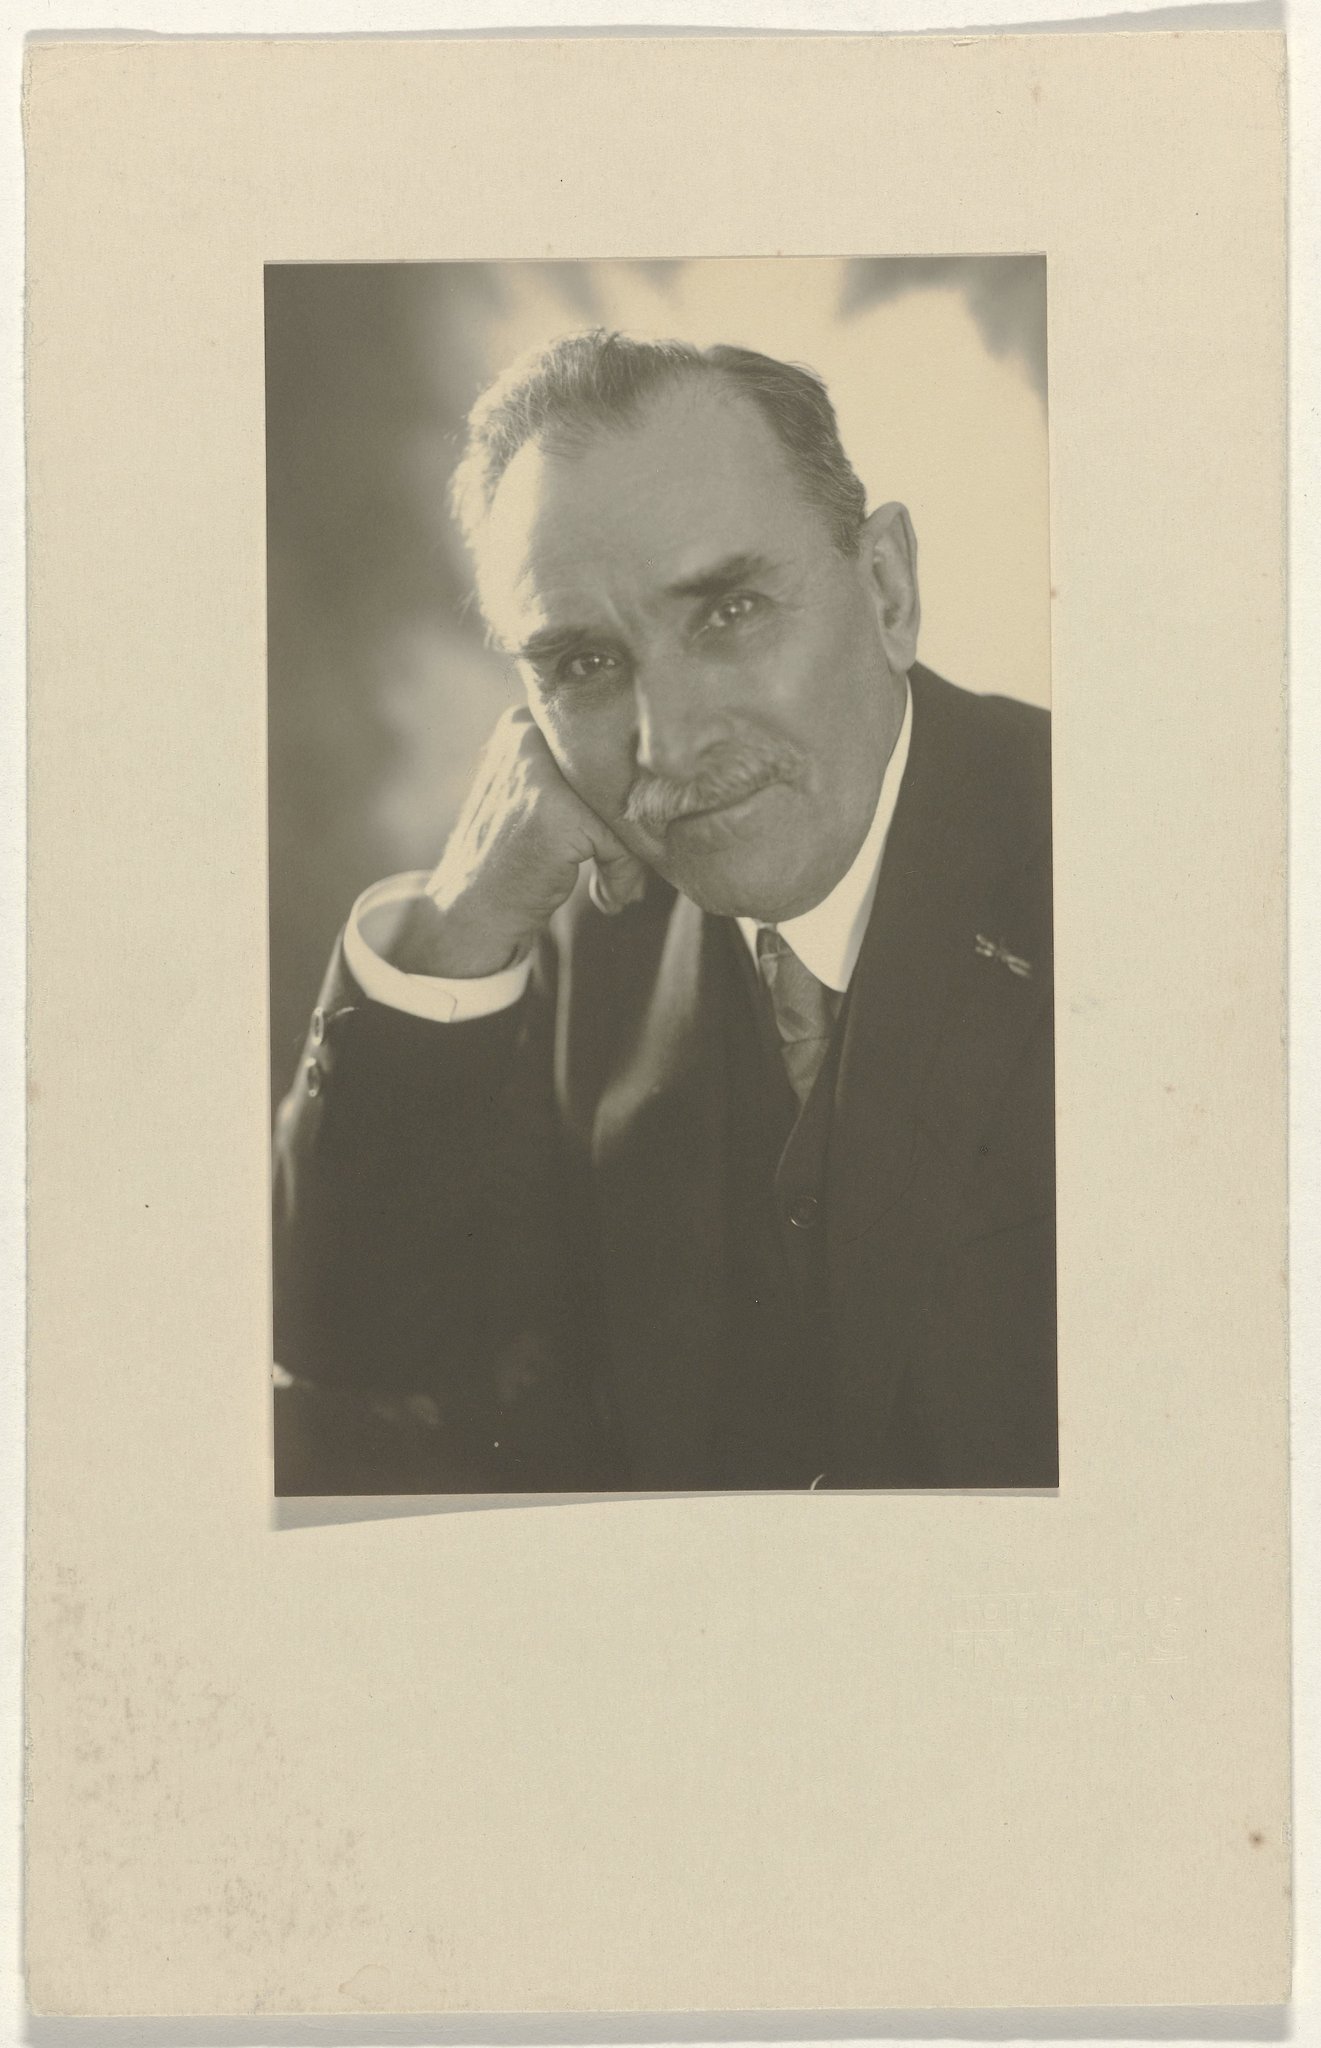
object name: photograph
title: Portret van Justus Gonggrijp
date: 1907-1928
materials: cardboard, photographic support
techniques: photography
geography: the hague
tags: dutch east indies, the, justus gonggrijp, suriname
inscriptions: date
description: Portret van Justus Gonggrijp. Onderdeel van een groep foto's van de familie Boom-Gonggrijp in Suriname.